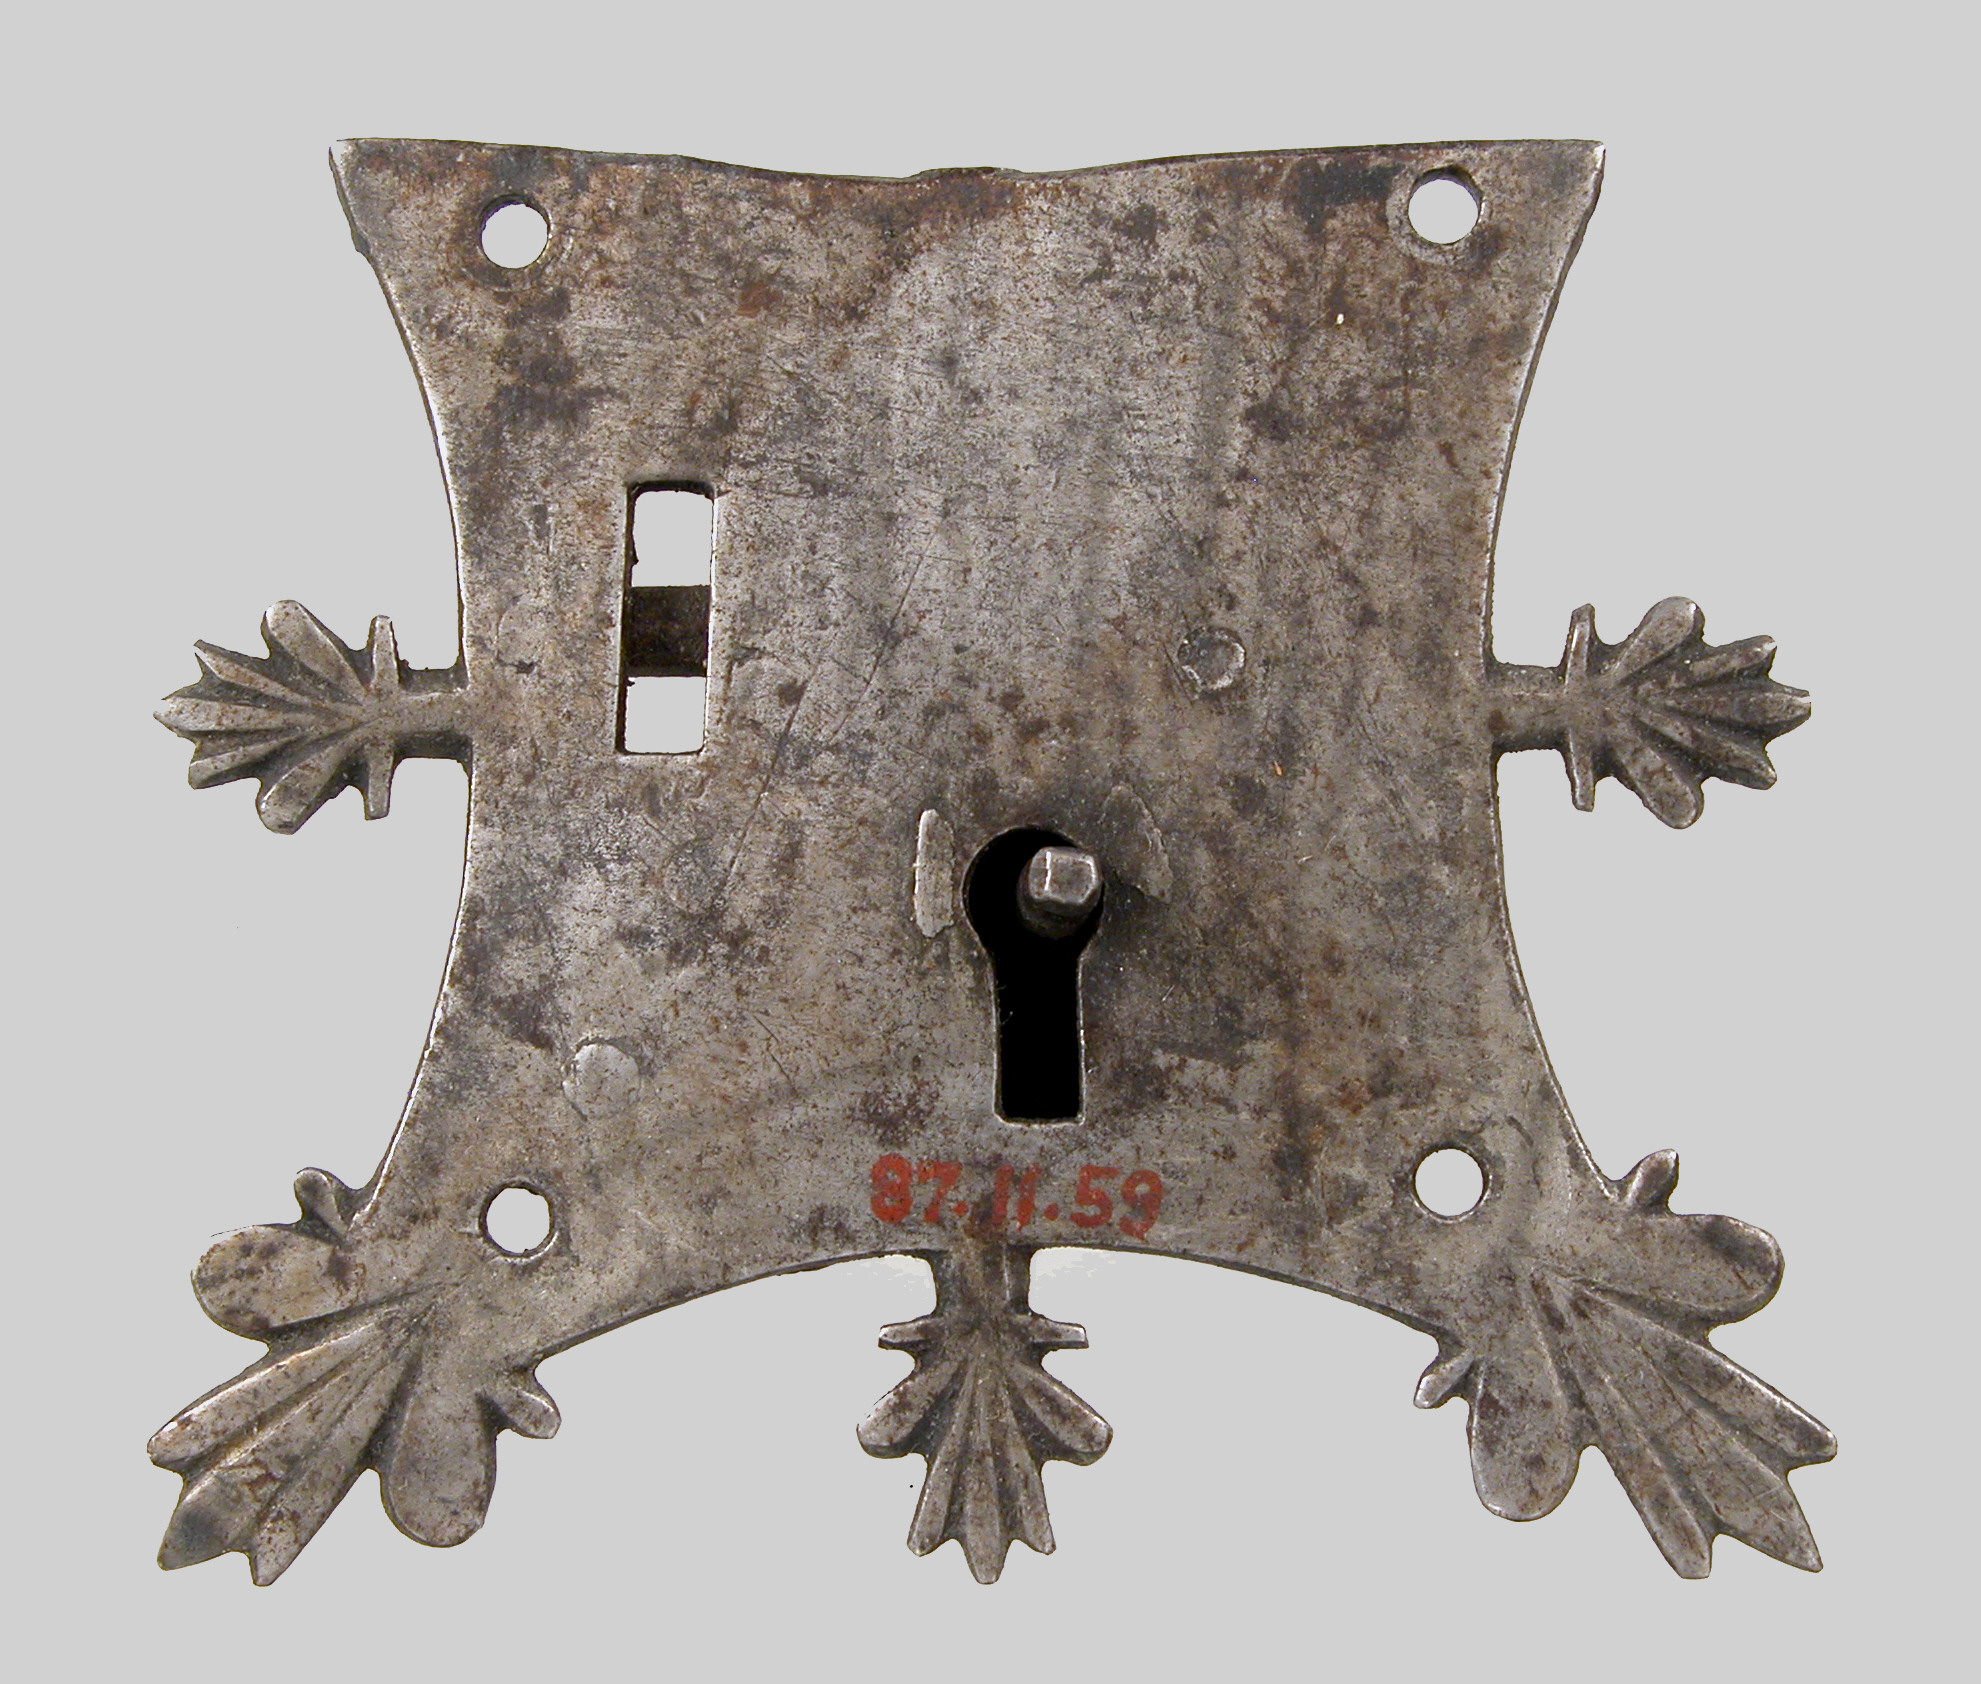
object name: mortise lock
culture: french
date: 1301-1400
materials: iron